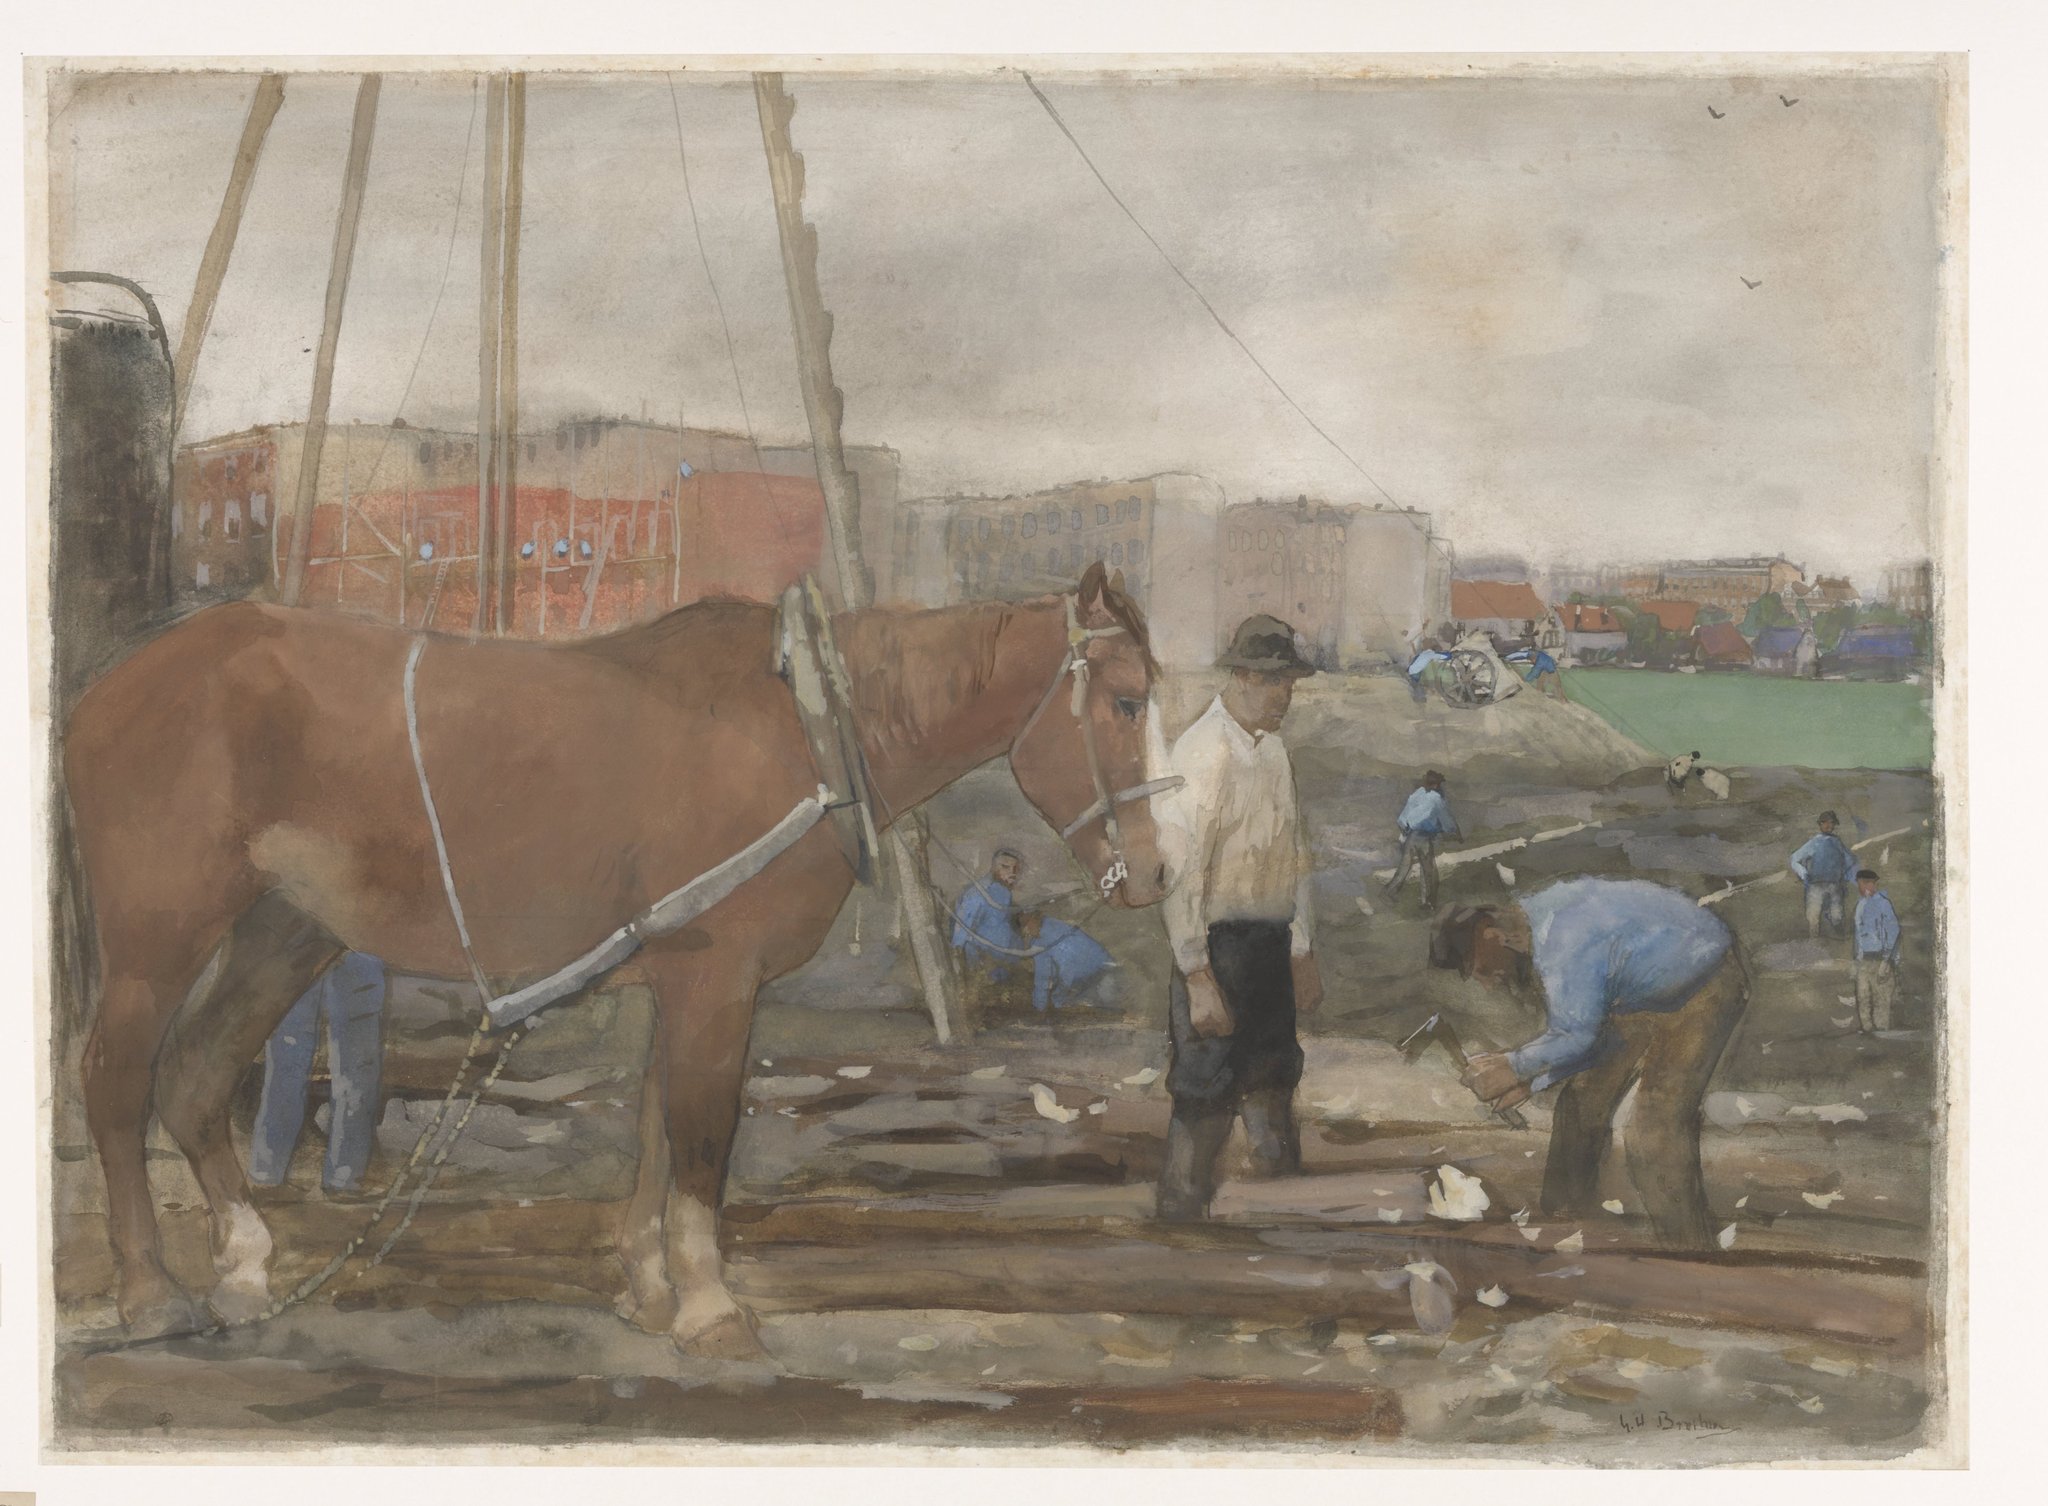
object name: watercolor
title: Bouwterrein Oud-West te Amsterdam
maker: george hendrik breitner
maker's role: draughtsman, painter, print maker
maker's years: 1857-1923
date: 1900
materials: paper, watercolor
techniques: brush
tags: building activities, horse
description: Bouwterrein, op de voorgrond een paard en arbeiders.